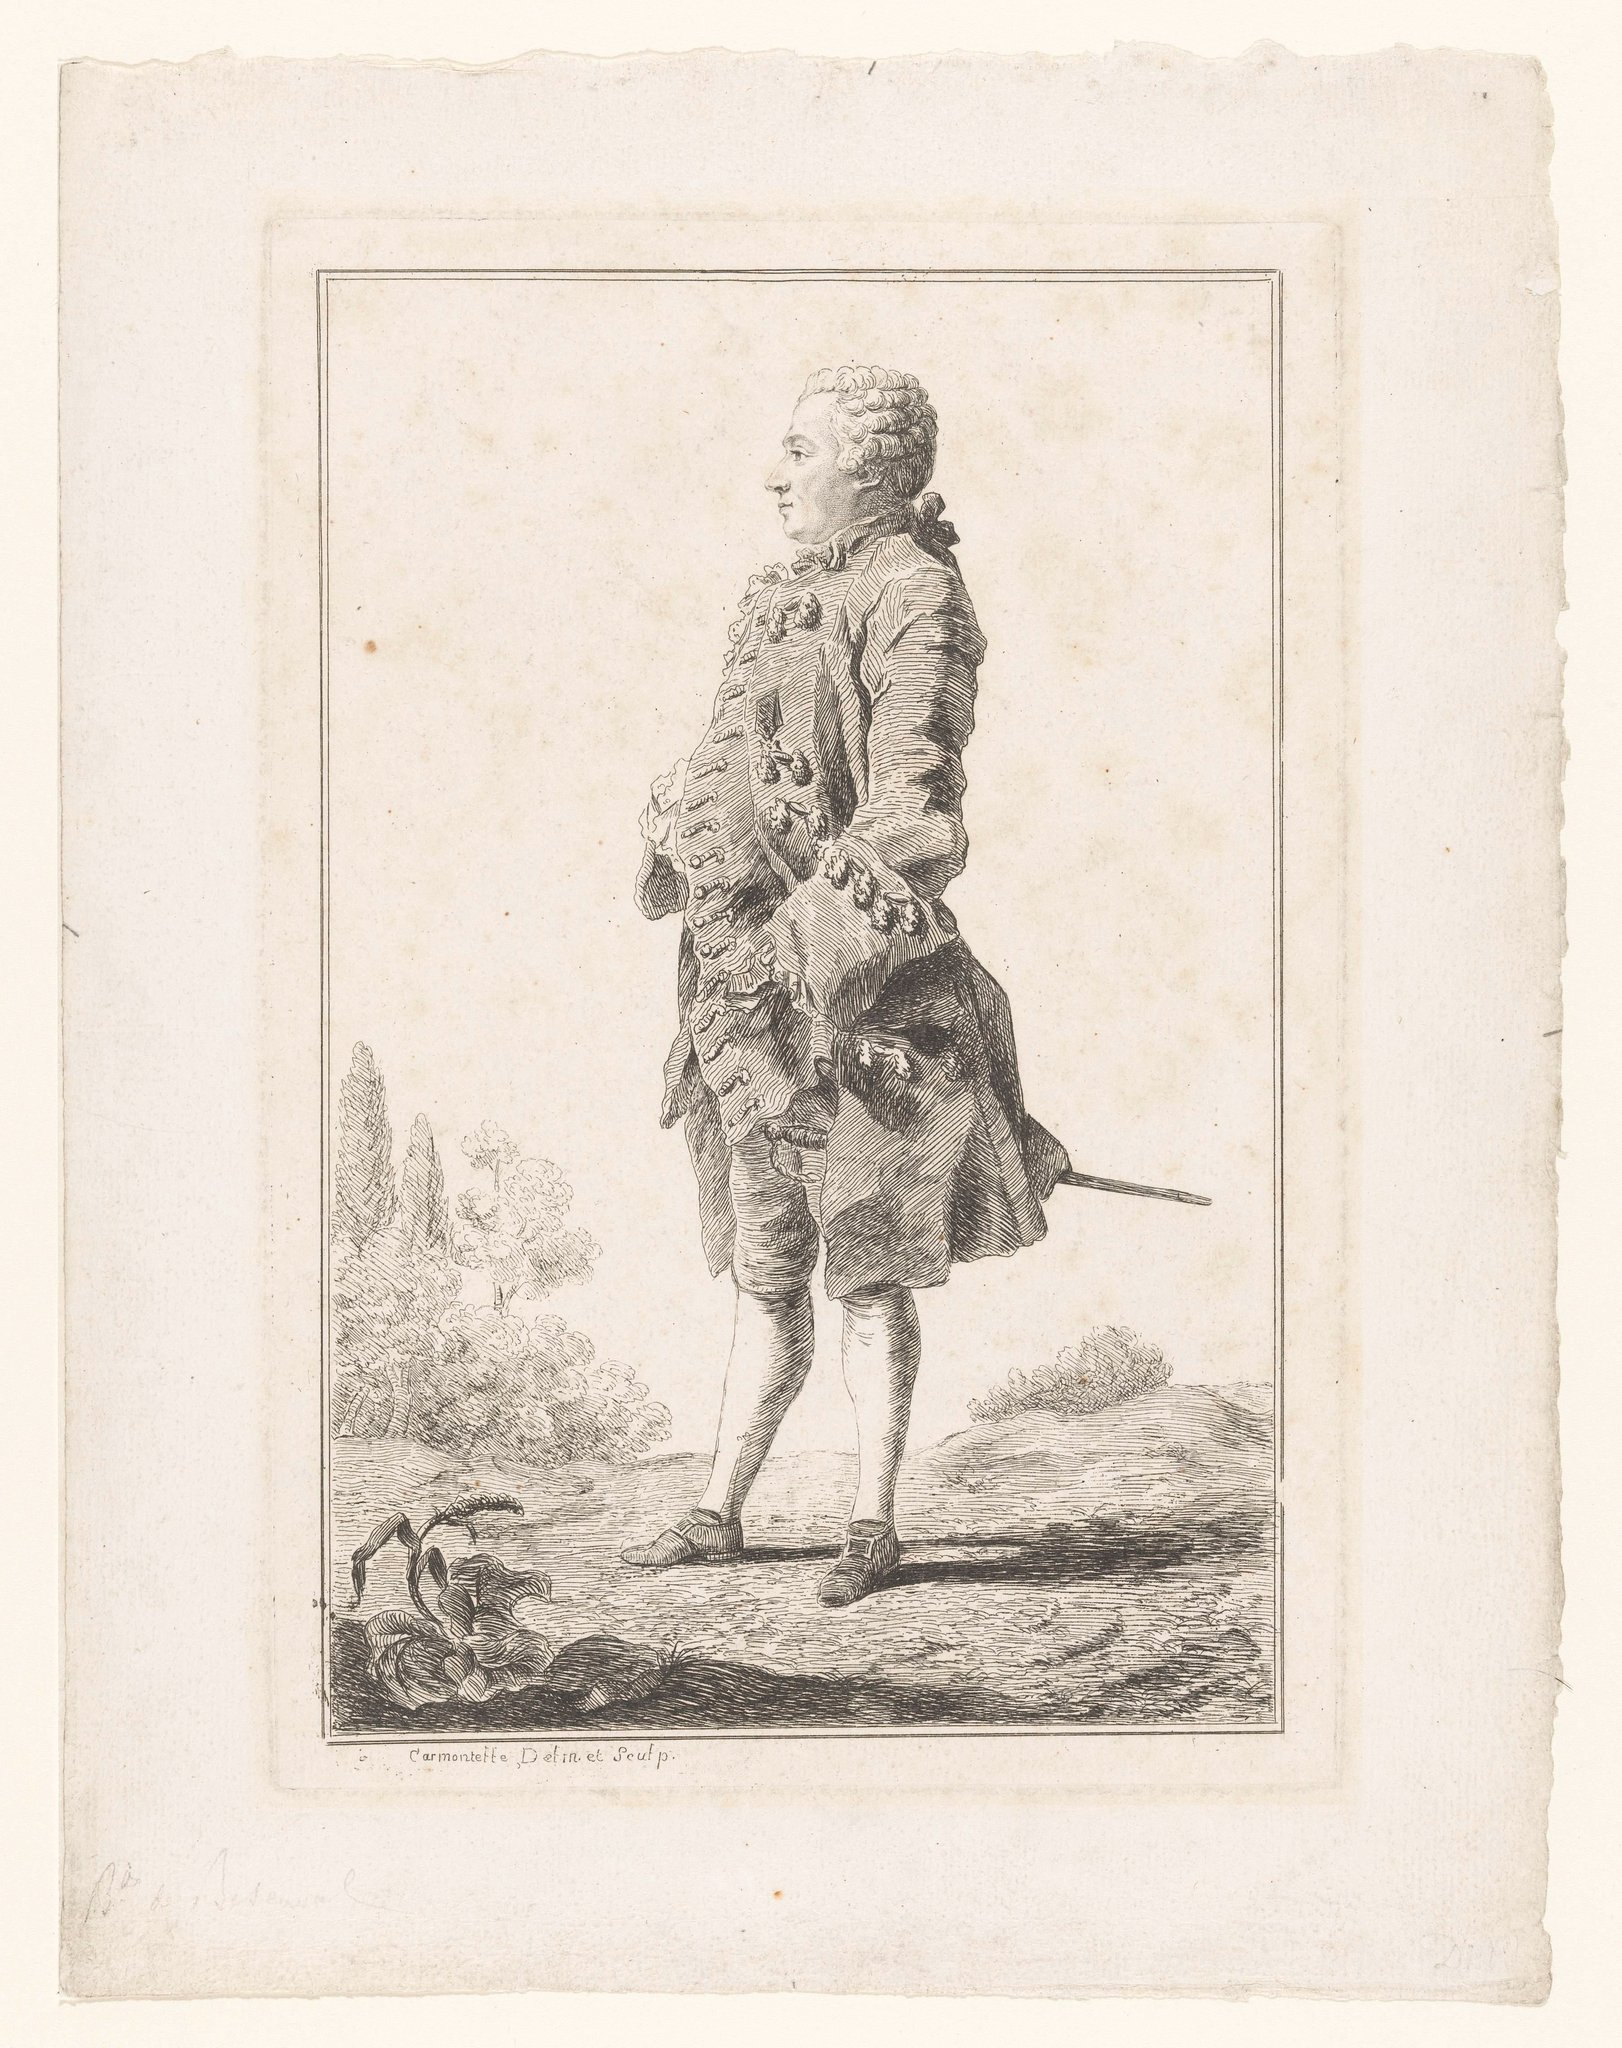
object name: print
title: Portret van Pierre Victor baron de Besenval de Brünstatt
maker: louis de carmontelle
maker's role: draughtsman, print maker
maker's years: 1717-1806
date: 1759-1806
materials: paper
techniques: etching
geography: france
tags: paris, historical persons, clothes, costume (+ men's clothes), wig, trousers, breeches, etc. (breeches) (+ men's clothes)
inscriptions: collector's mark: Lugt 2760, signature: ‘Carmontelle Delin. et Sculp.’, collector's mark: Lugt 1221, collector's mark: Lugt 2228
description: De baron de Besenval, staand in een landschap, naar links gekeerd. Hij is gekleed in een overjas, kniebroek met lange kousen en schoenen met gespen. Op zijn hoofd draagt hij een staartpruik.